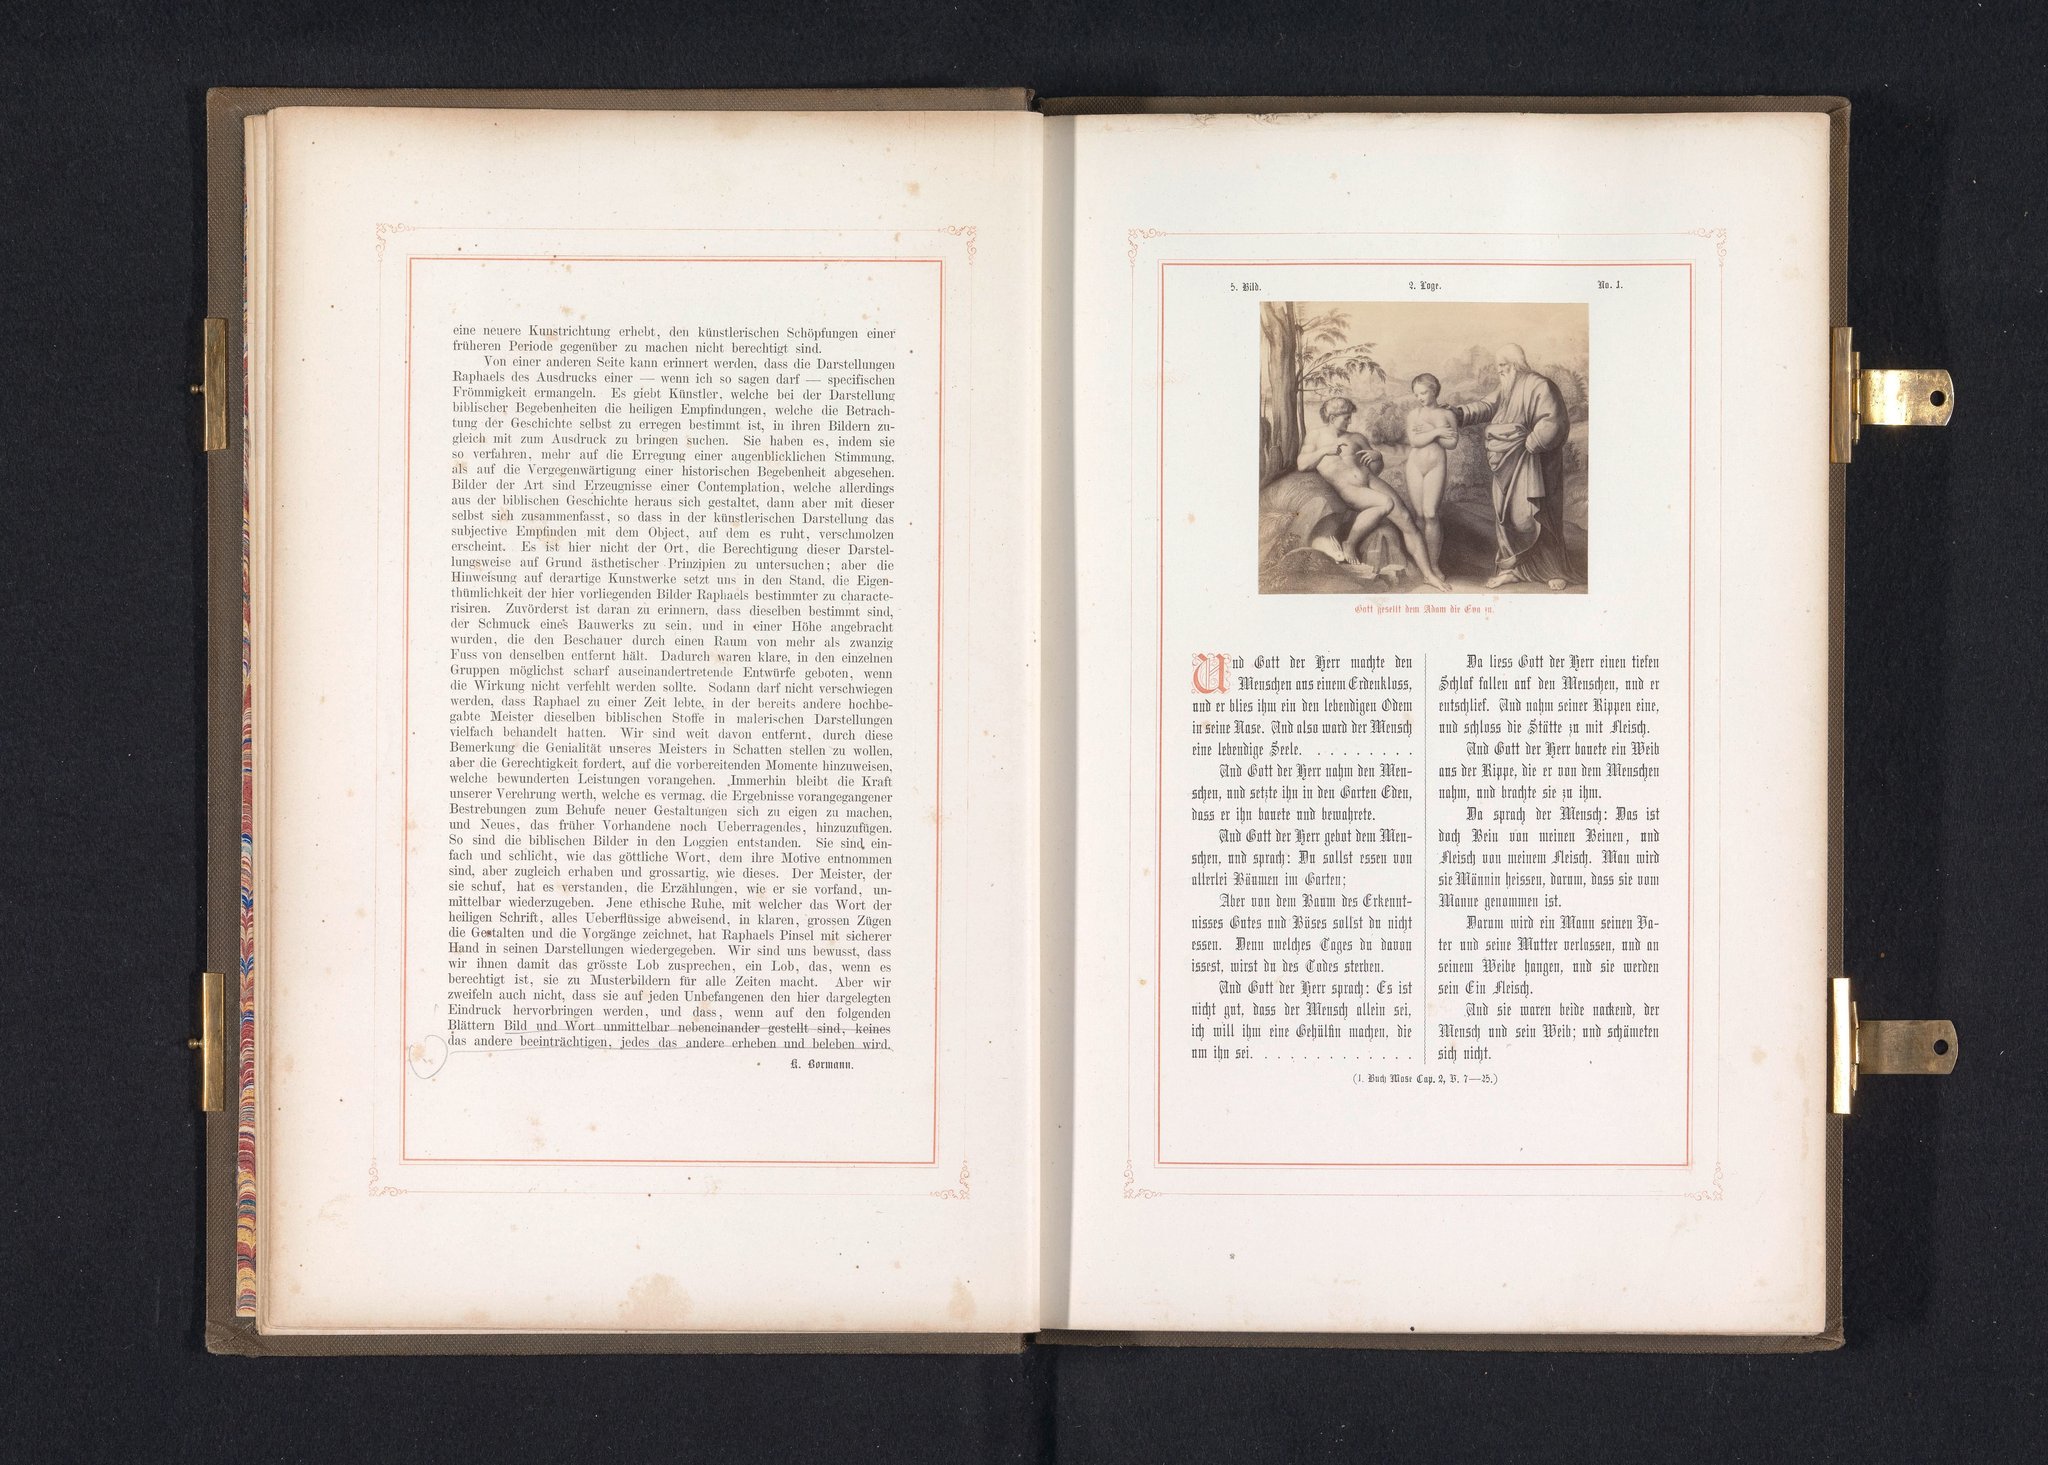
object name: photograph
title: Gott gesellt dem Adam die Eva zu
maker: gustav schauer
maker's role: painter, publisher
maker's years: 1826-1902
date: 1851-1861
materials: photographic support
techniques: albumen print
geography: berlin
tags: genesis from the creation to the expulsion from paradise, and later years of adam and eve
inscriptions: inscription: ‘5. Bild. 2. Loge. No.1’